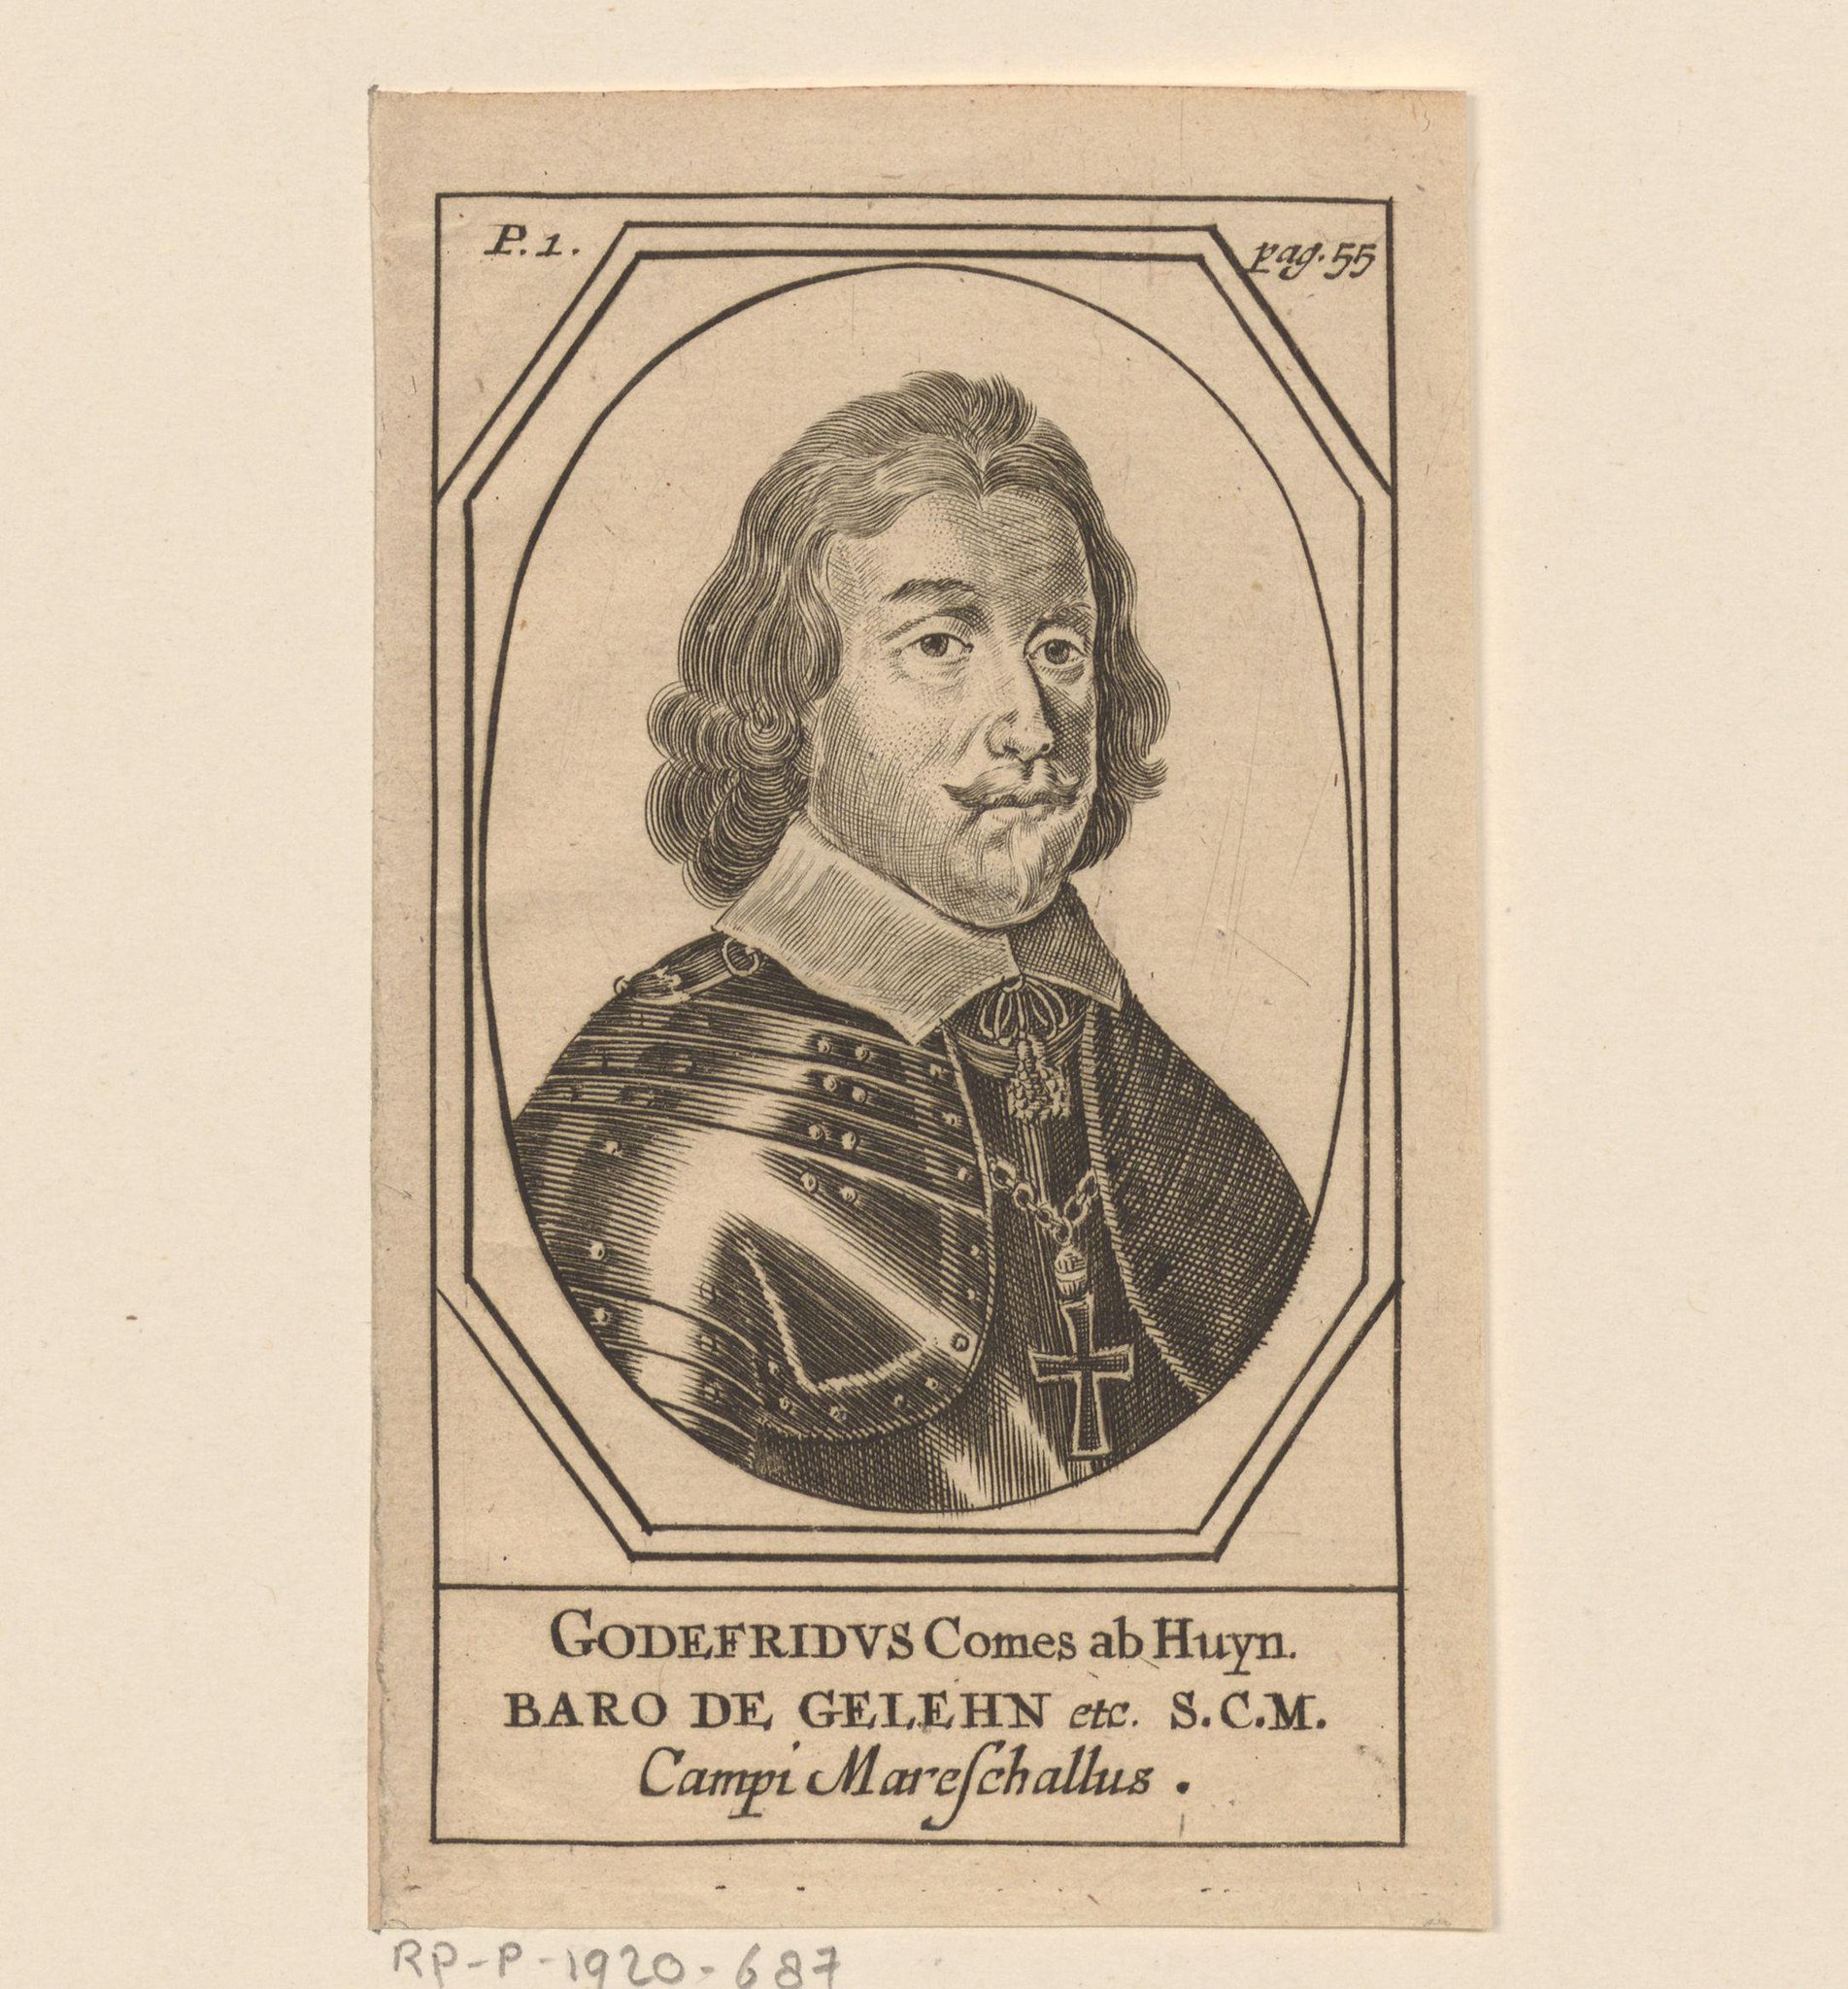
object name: book illustration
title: Portret van Godfried Huyn van Geleen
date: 1655-1659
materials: paper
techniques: engraving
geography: amsterdam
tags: maastricht, commander-in-chief, general, marshal, armour, historical persons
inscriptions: collector's mark: Lugt 2228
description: Prent uit: Brachelius, Johannes Adolphus. Historiarum nostri temporis editio ultima (…). Amsterdam: Jacob van Meurs en Johannes Janssonius, 1655. Prent ook gebruikt in de tweede editie van 1659.